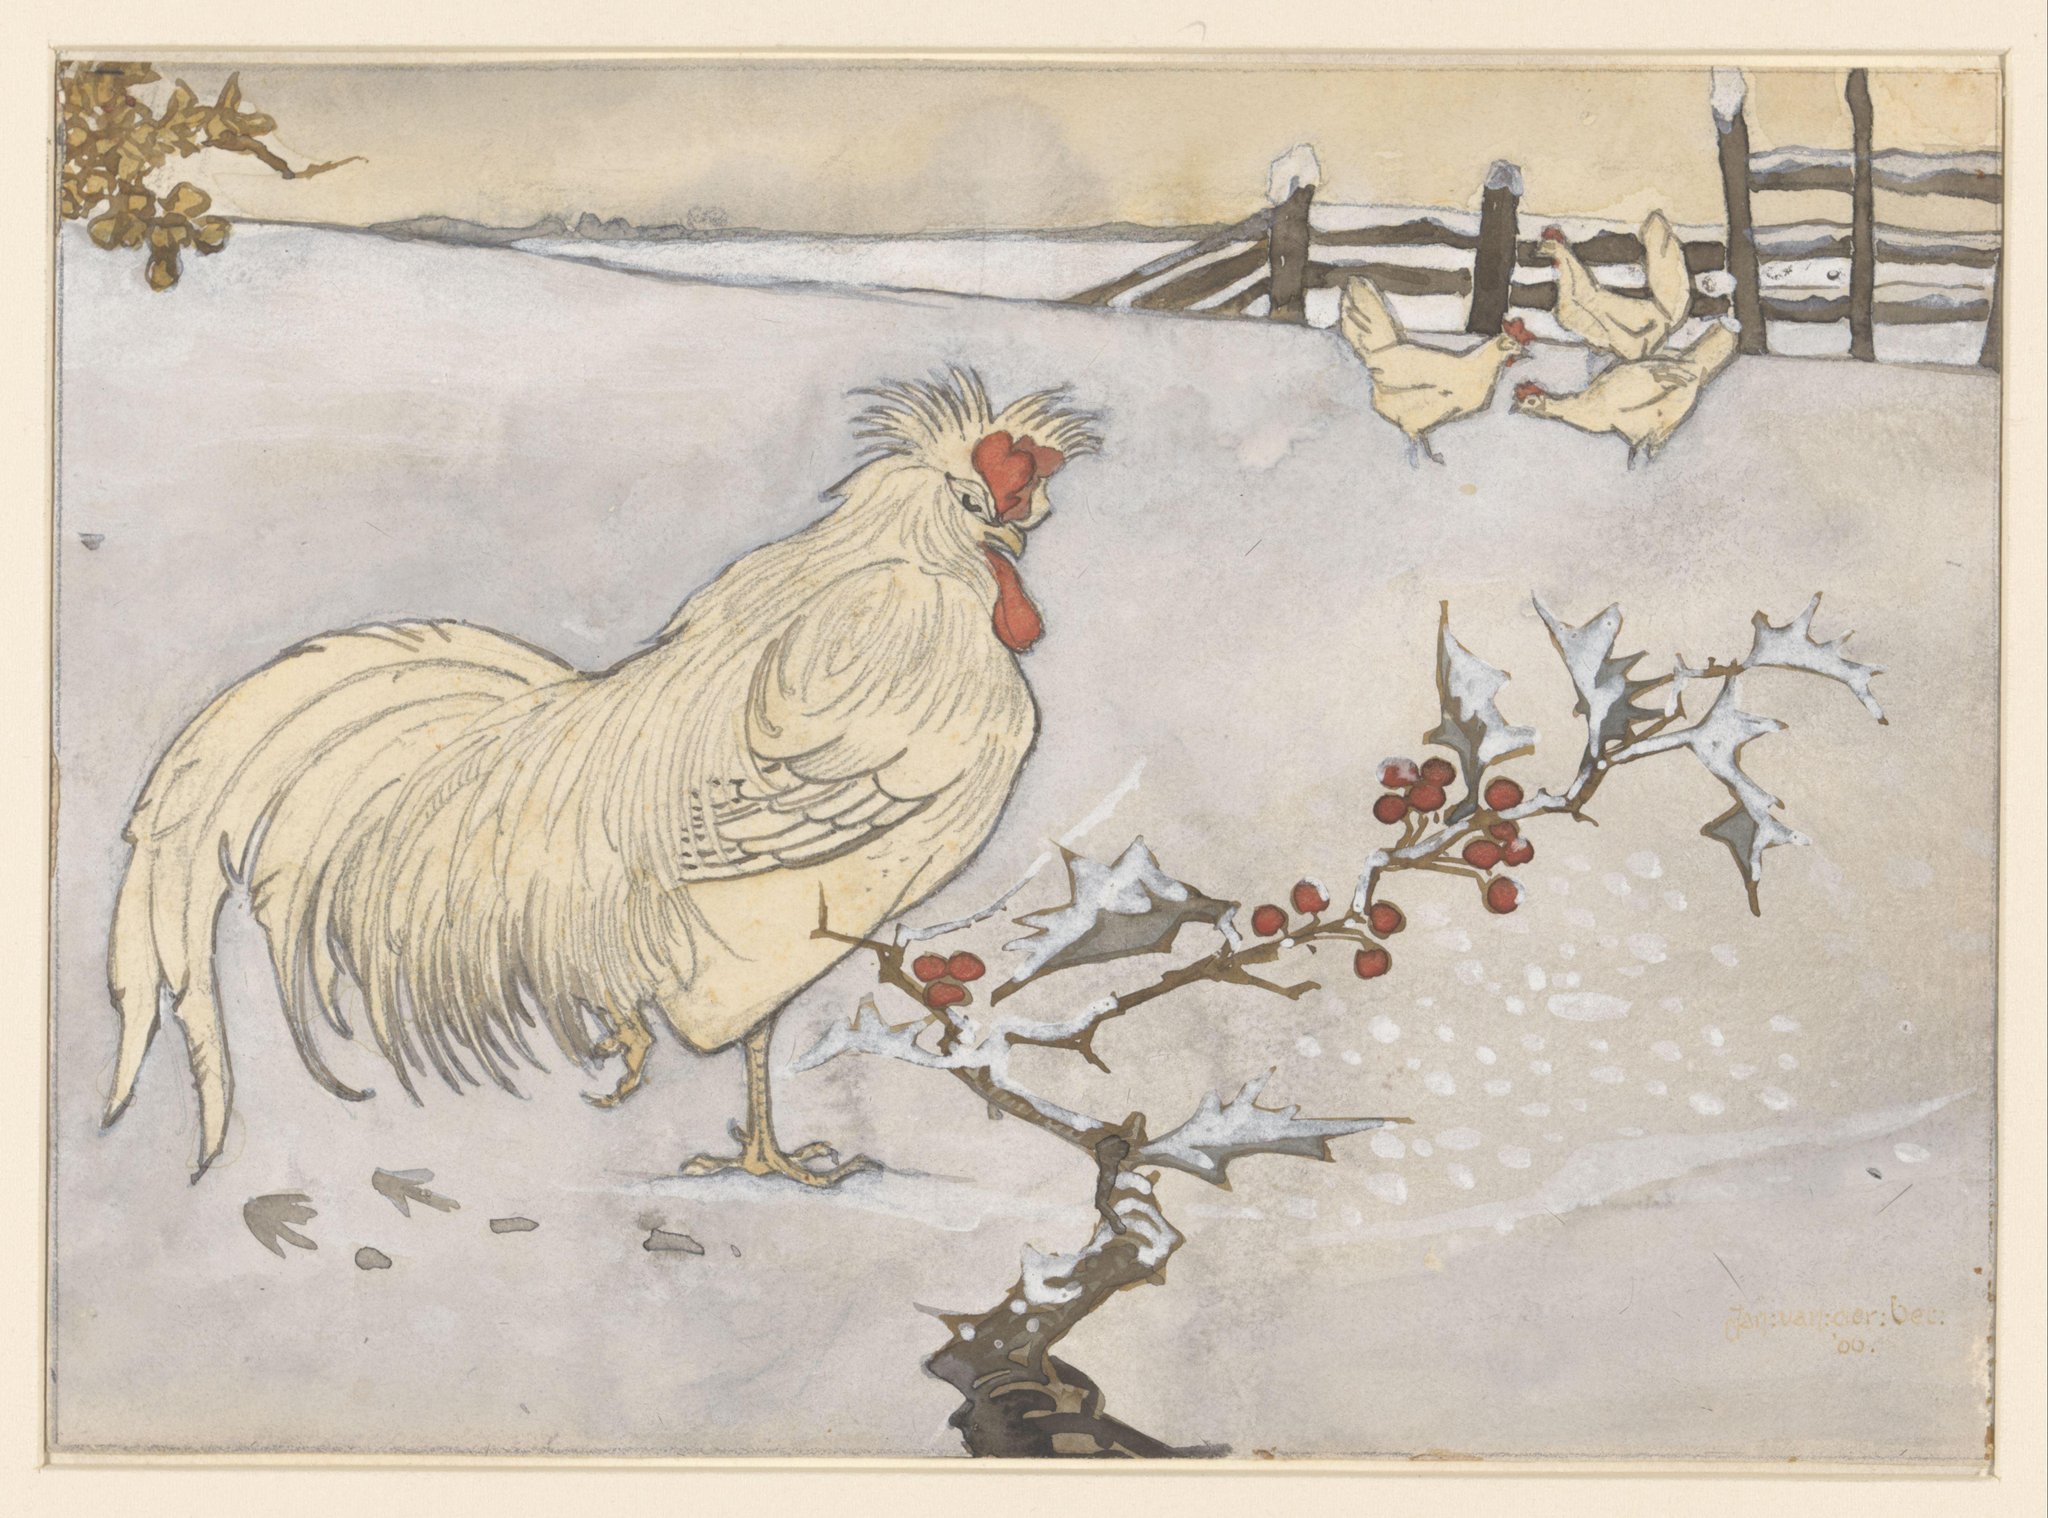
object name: drawing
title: Haan en drie kippen in een sneeuwlandschap met een tak hulst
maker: jan c. van der ven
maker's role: draughtsman, print maker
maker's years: 1896-1930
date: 1906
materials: paper, pencil, watercolor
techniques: brush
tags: trees: holly, fowl (cock, hen, chicken, etc.) (+ male animal), fowl (cock, hen, chicken, etc.) (+ female animal)